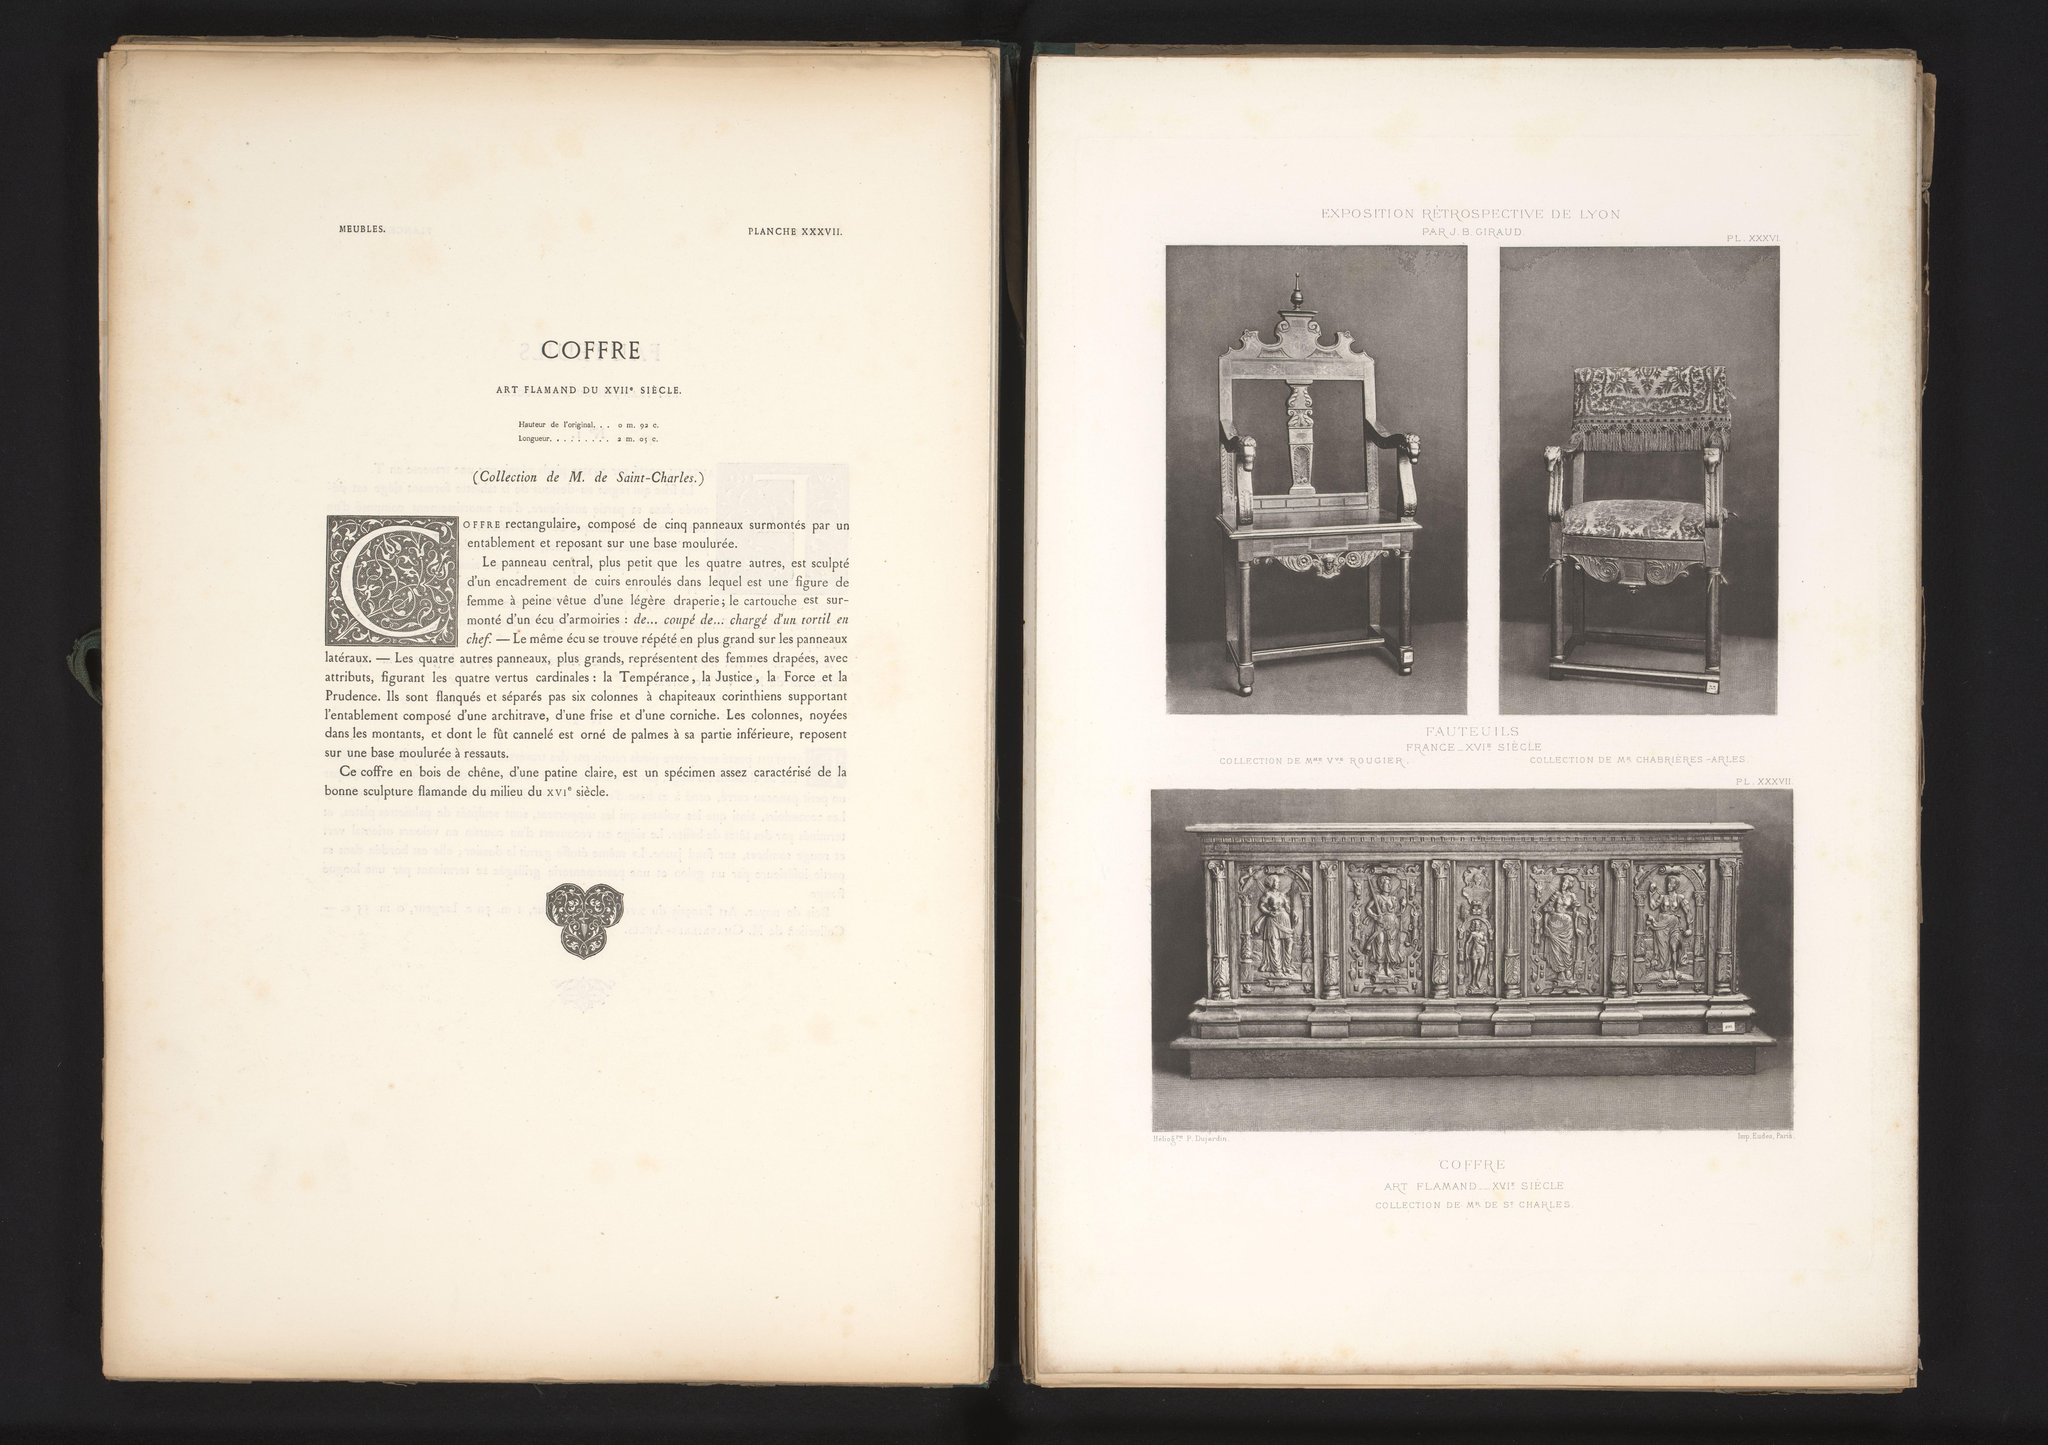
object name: photomechanical print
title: Twee 16de-eeuwse Franse stoelen van hout en een 16de-eeuwse Vlaamse kist van hout, op de Exposition Rétrospective van 1877 in Lyon, Frankrijk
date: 1877-1878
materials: paper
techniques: photoaquatint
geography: lyon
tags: chest, coffer (+ wood and other phytogenic material), chair (+ wood and other phytogenic material), lyon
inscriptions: inscription: ‘COFFRE/ ART FLAMAND_XVIe SIÈCLE/ COLLECTION DE Mr DE St CHARLES.’, number: ‘PL. XXXVII.’, number: ‘PL. XXXVI.’, inscription: ‘FAUTEUILS/ FRANCE_XVIe SIÈCLE/ COLLECTION DE Mme Vve ROUGIER. COLLECTION DE Mr CHARIÈRES-ARLES.’, inscription: ‘EXPOSITION RÉTROSPECTIVE DE LYON/ PAR J. B. GIRAUD.’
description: Deze prenten maken deel uit van een omslag met 79 prenten op 54 bladen en 65 tekstbladen.